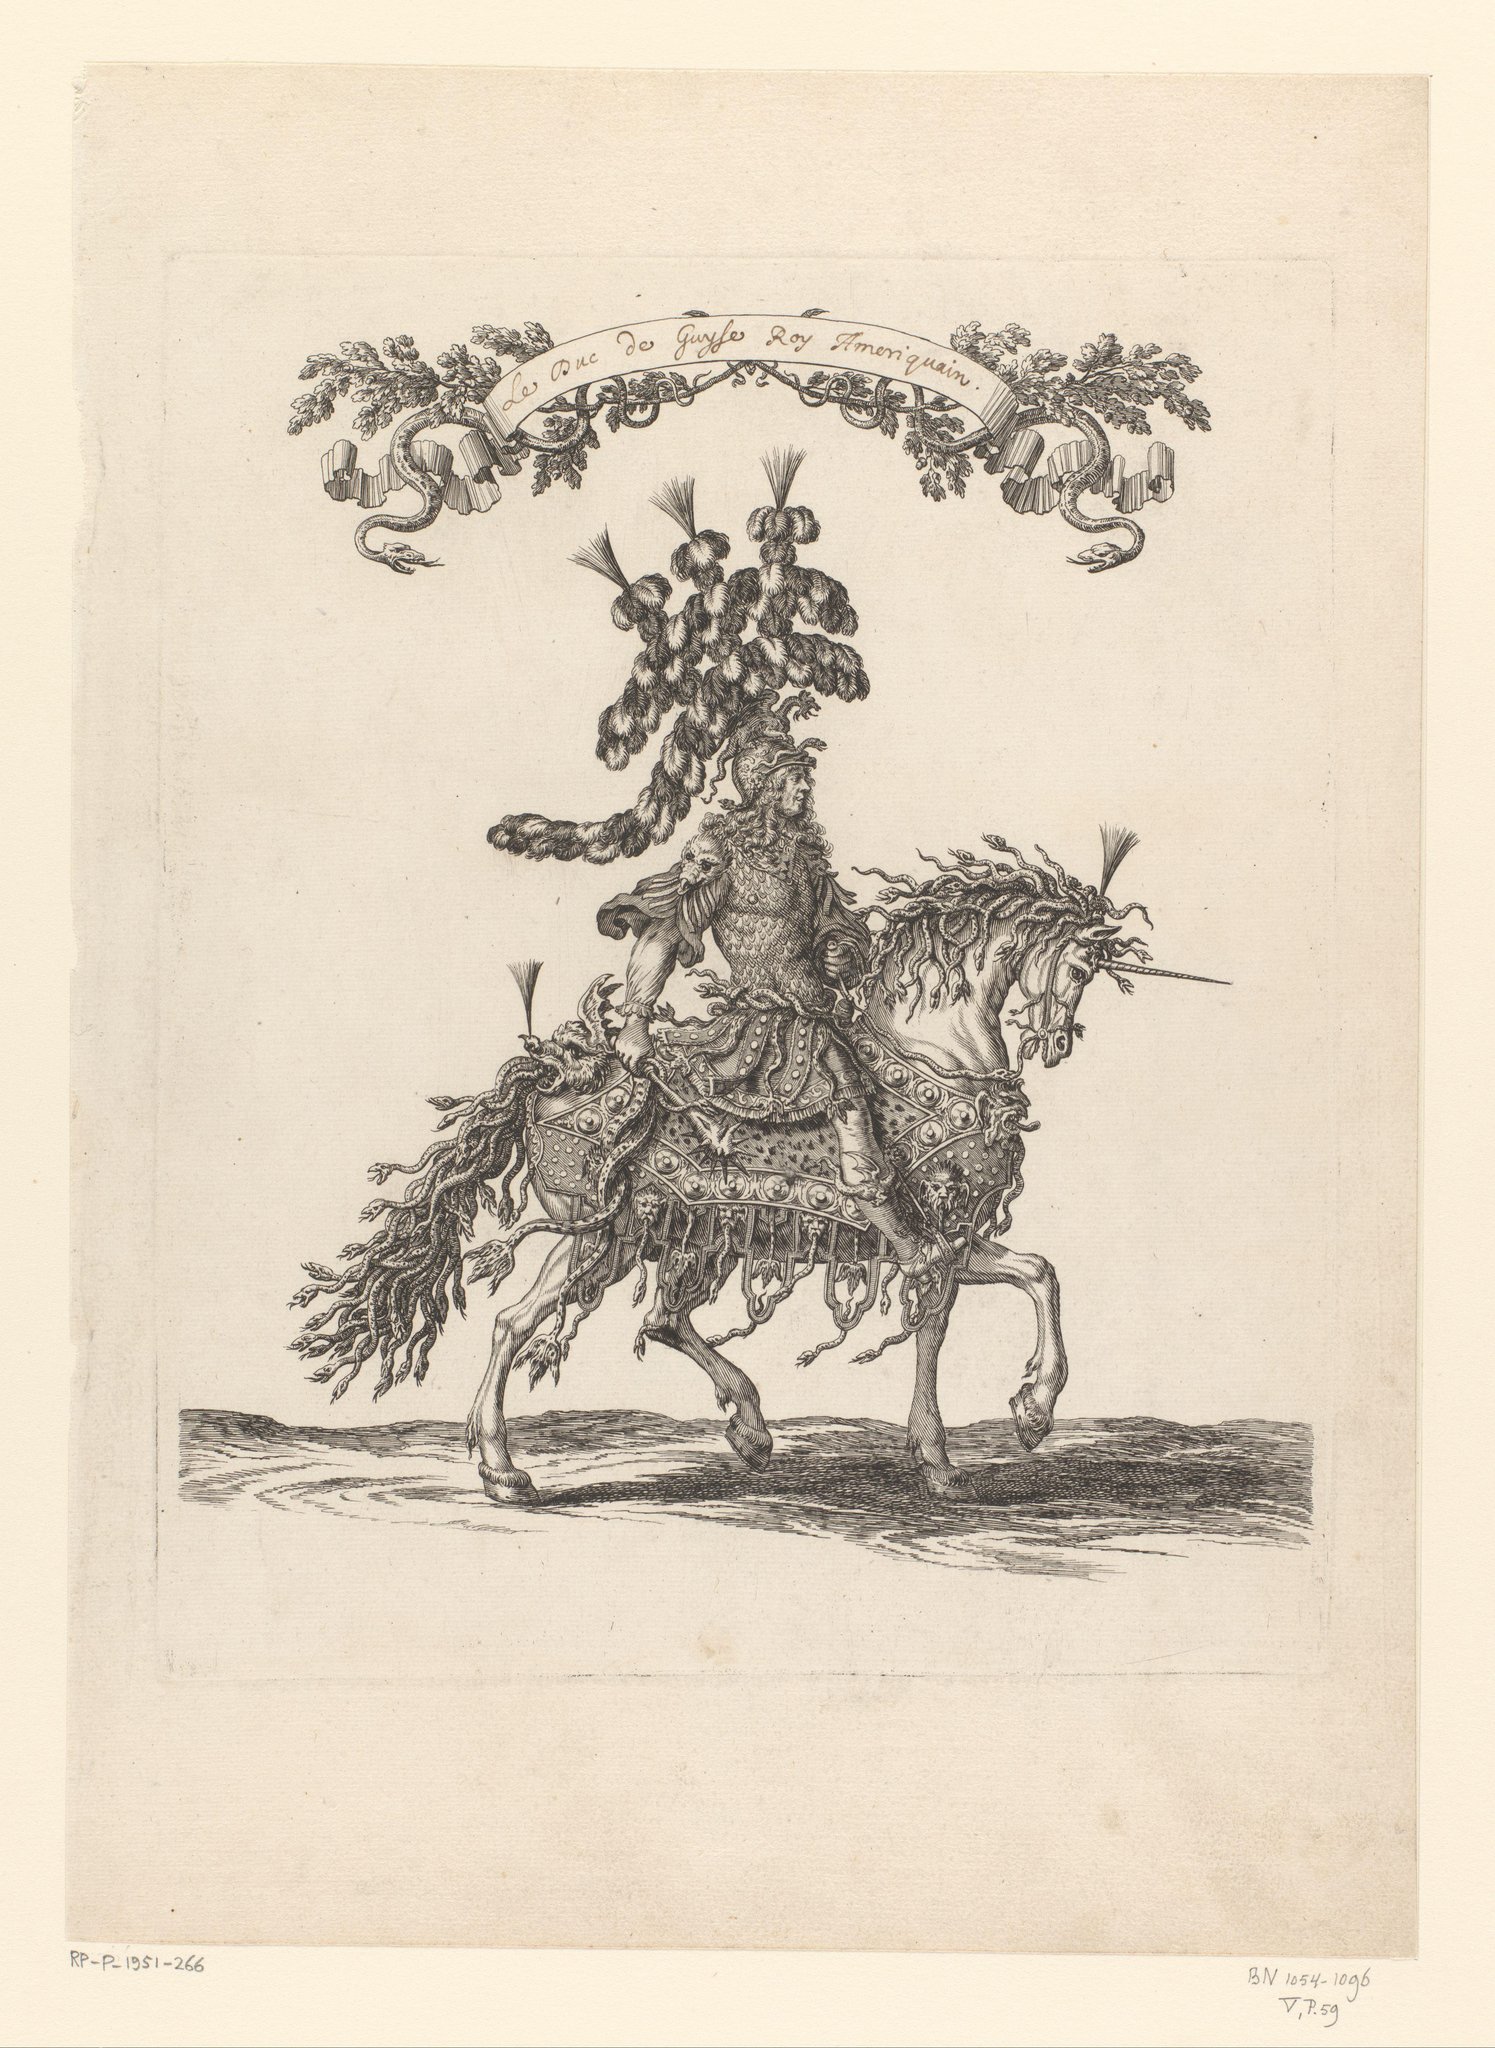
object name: print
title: Le Duc de Guyse Roy Amériquain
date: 1670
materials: paper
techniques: etching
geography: paris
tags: paris, unicorn, tournament, historical persons, horse, festivities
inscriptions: collector's mark: Lugt 2228, inscription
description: Prent uit: Perrault, Charles. Courses de testes et de bague faites par le Roy et par les princes et seigneurs de sa cour en l'année M.DC.LXII. Parijs: Imprimerie Royale, 1670. De prenten illustreren de door Lodewijk XIV georganiseerde festiviteiten in juni 1662 te Tuileries, zoals steekspelen met figuren in verschillende kostuums.